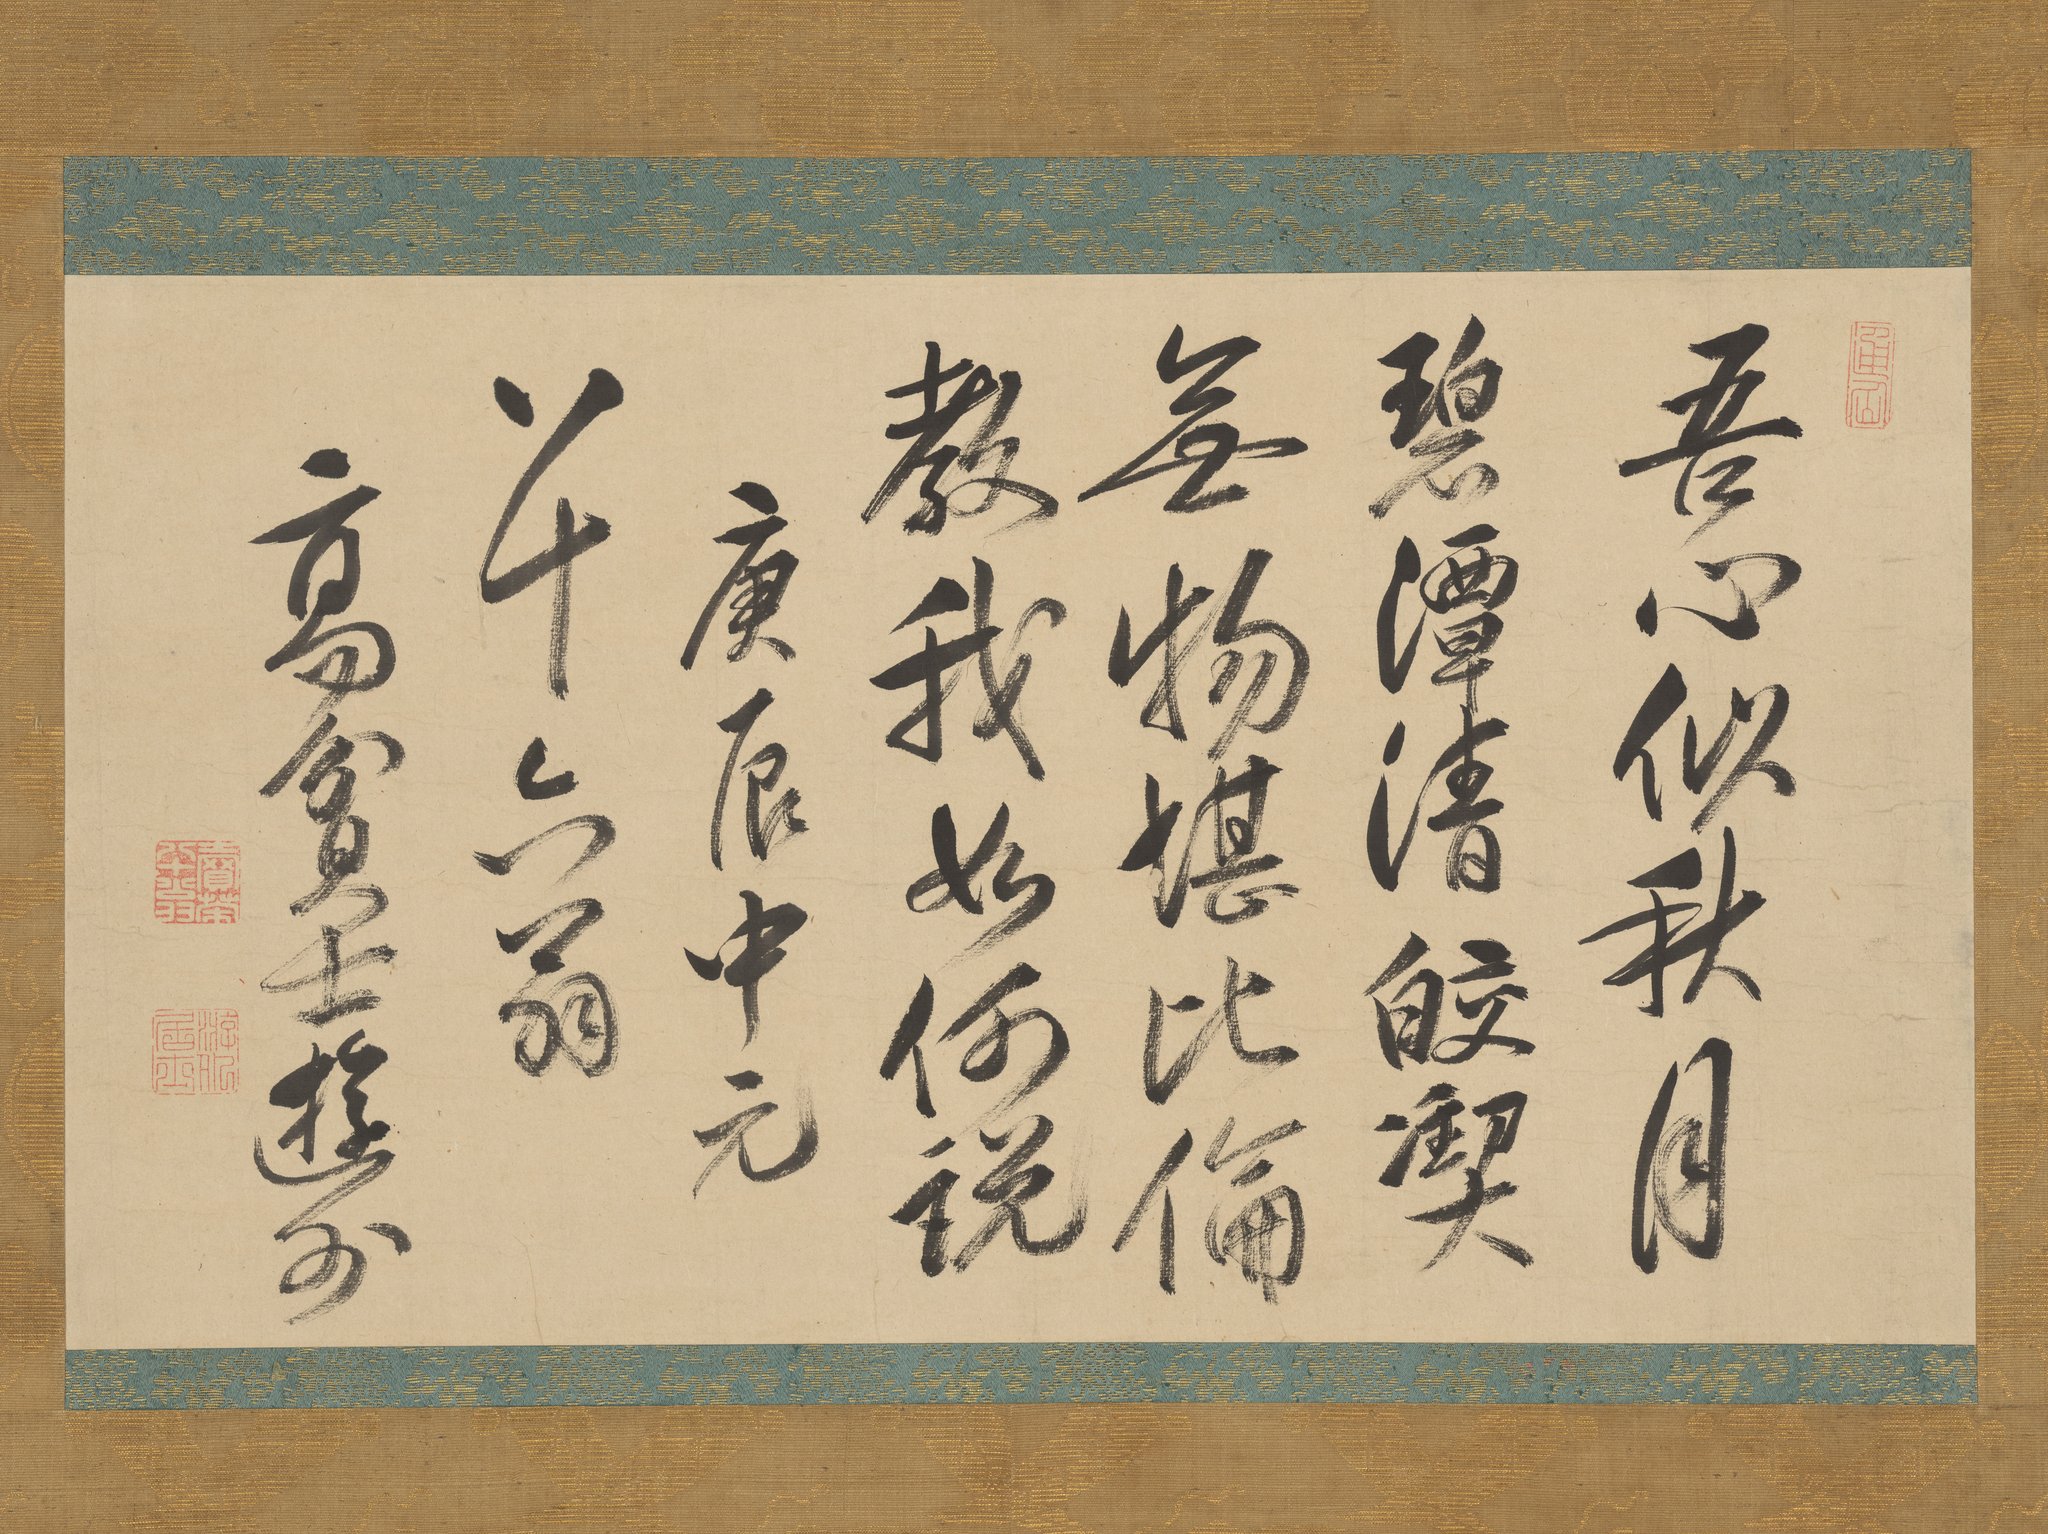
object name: hanging scroll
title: Chinese Poem on the Autumn Moon by Hanshan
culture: japanese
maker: baisaō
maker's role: artist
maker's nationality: japanese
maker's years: 1675-1763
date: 1760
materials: ink, paper